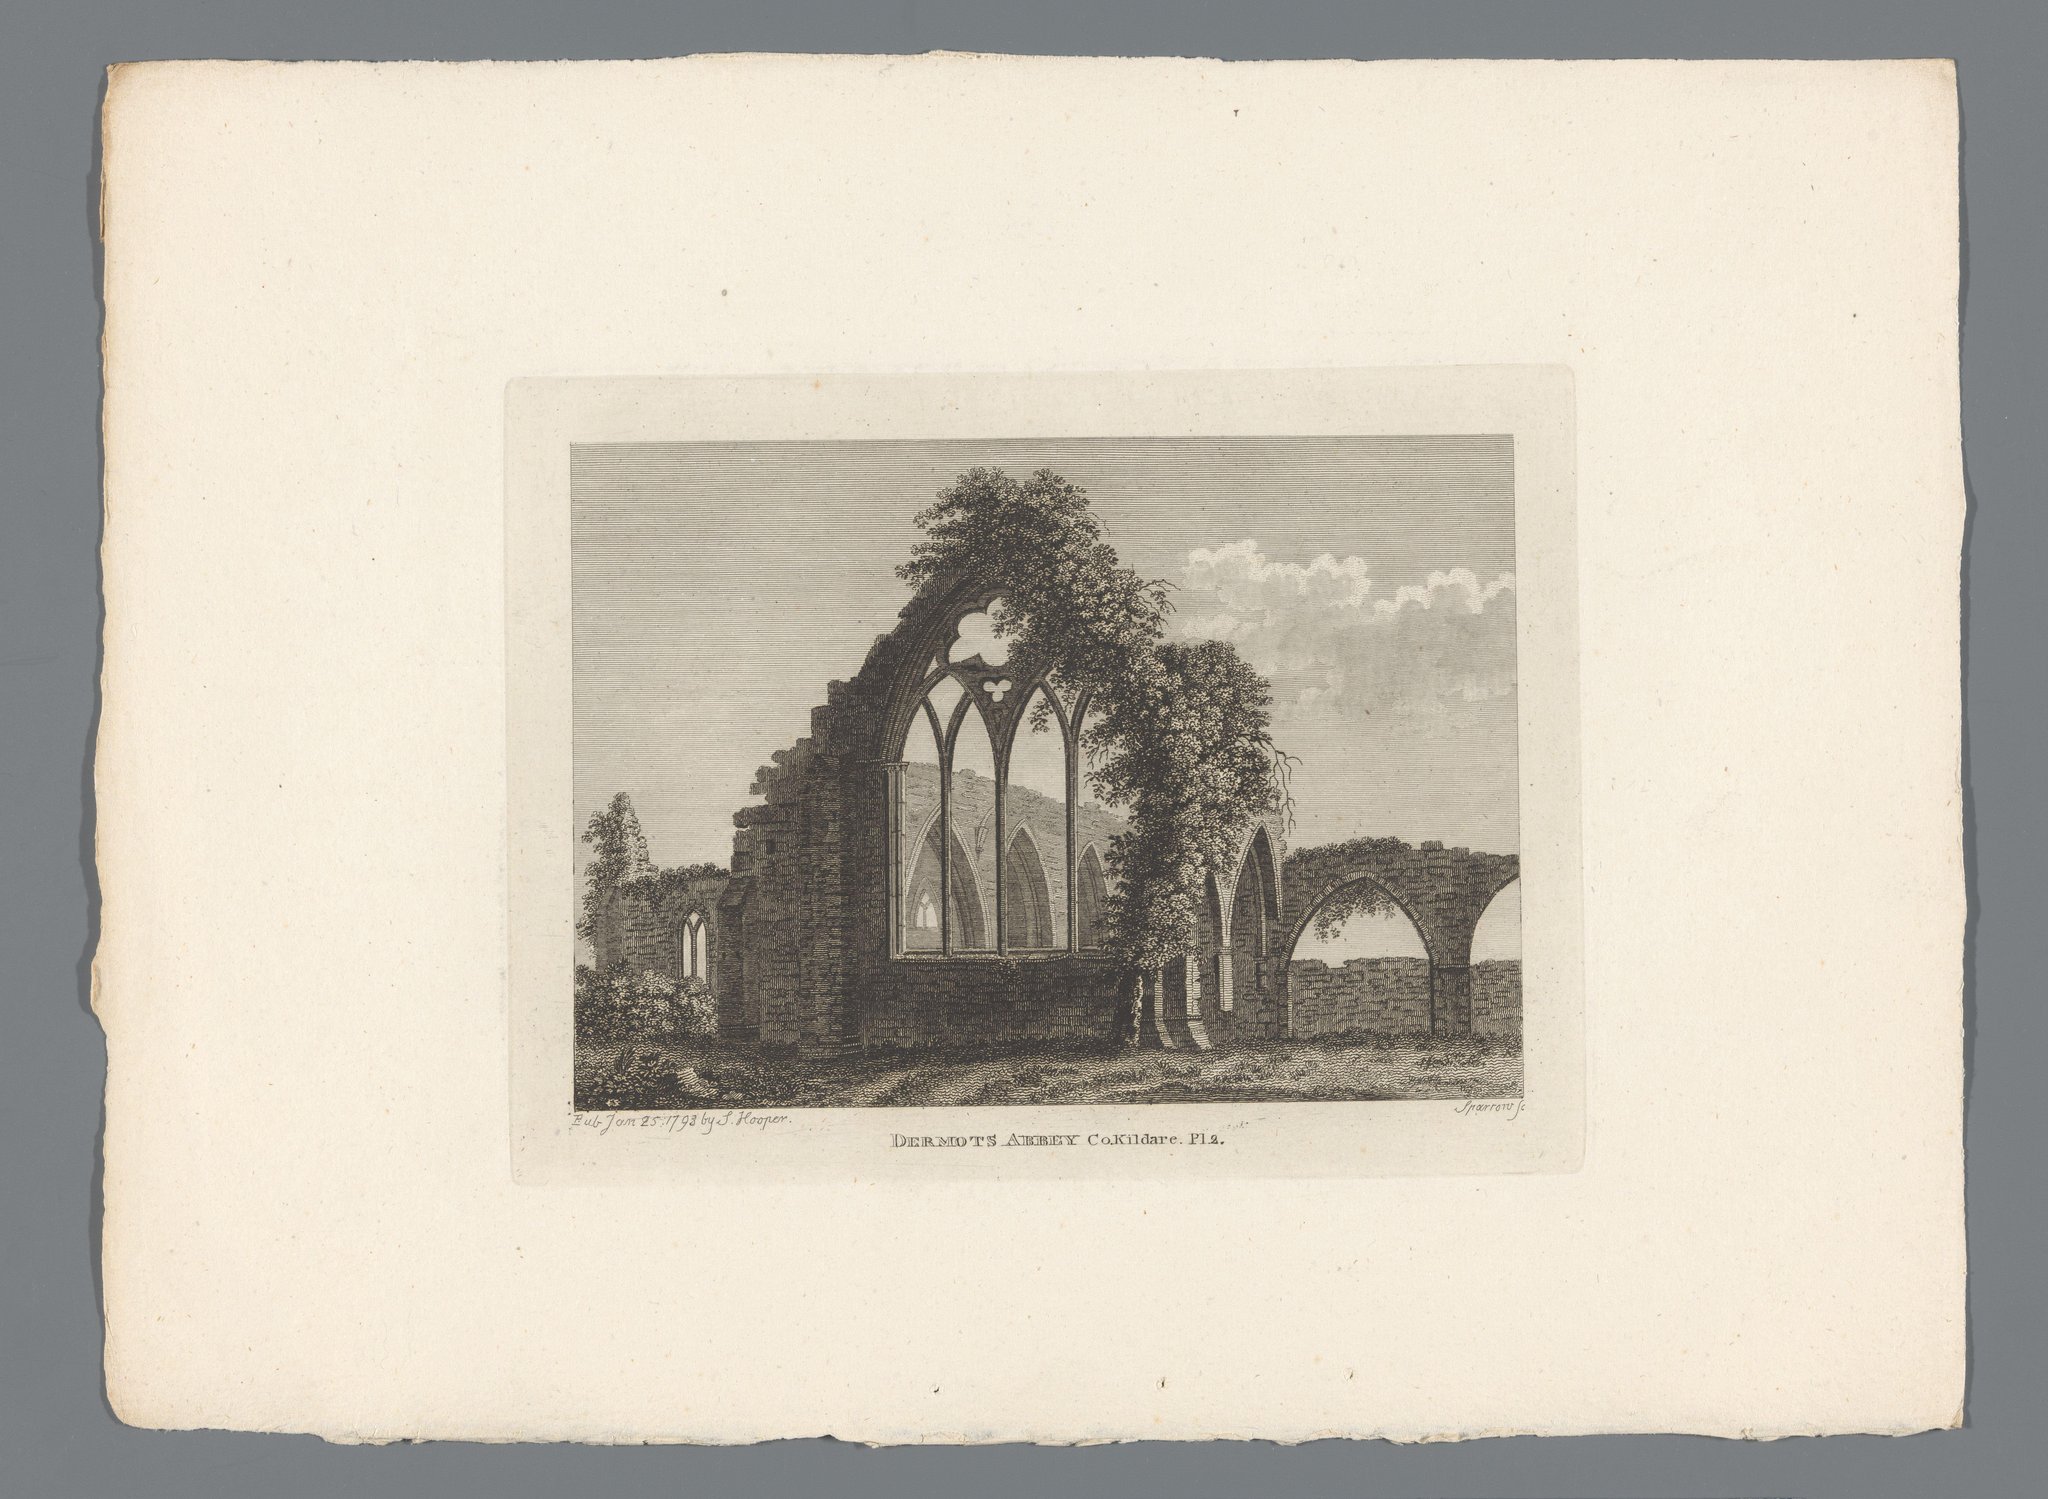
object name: book illustration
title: Gezicht op de ruïnes van de abdij van Dermot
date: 1793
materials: paper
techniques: etching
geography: london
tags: abbey, monastery, convent ~ roman catholic church, landscape with ruins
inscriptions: date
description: Prent verschenen in: Grose, Francis. The antiquities of Ireland. Londen: S. Hooper, 1795, dl. 2.